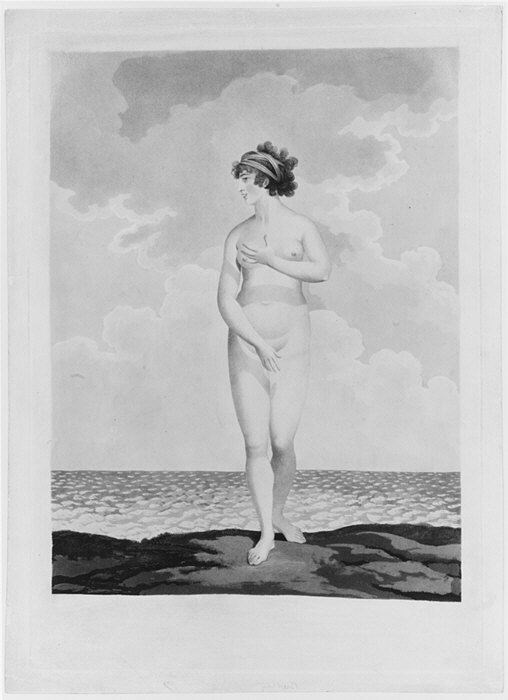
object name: print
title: Venus, or the Bath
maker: joseph constantine stadler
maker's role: artist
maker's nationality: german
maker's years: 1780-1822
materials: watercolor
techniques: aquatint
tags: female nudes,venus